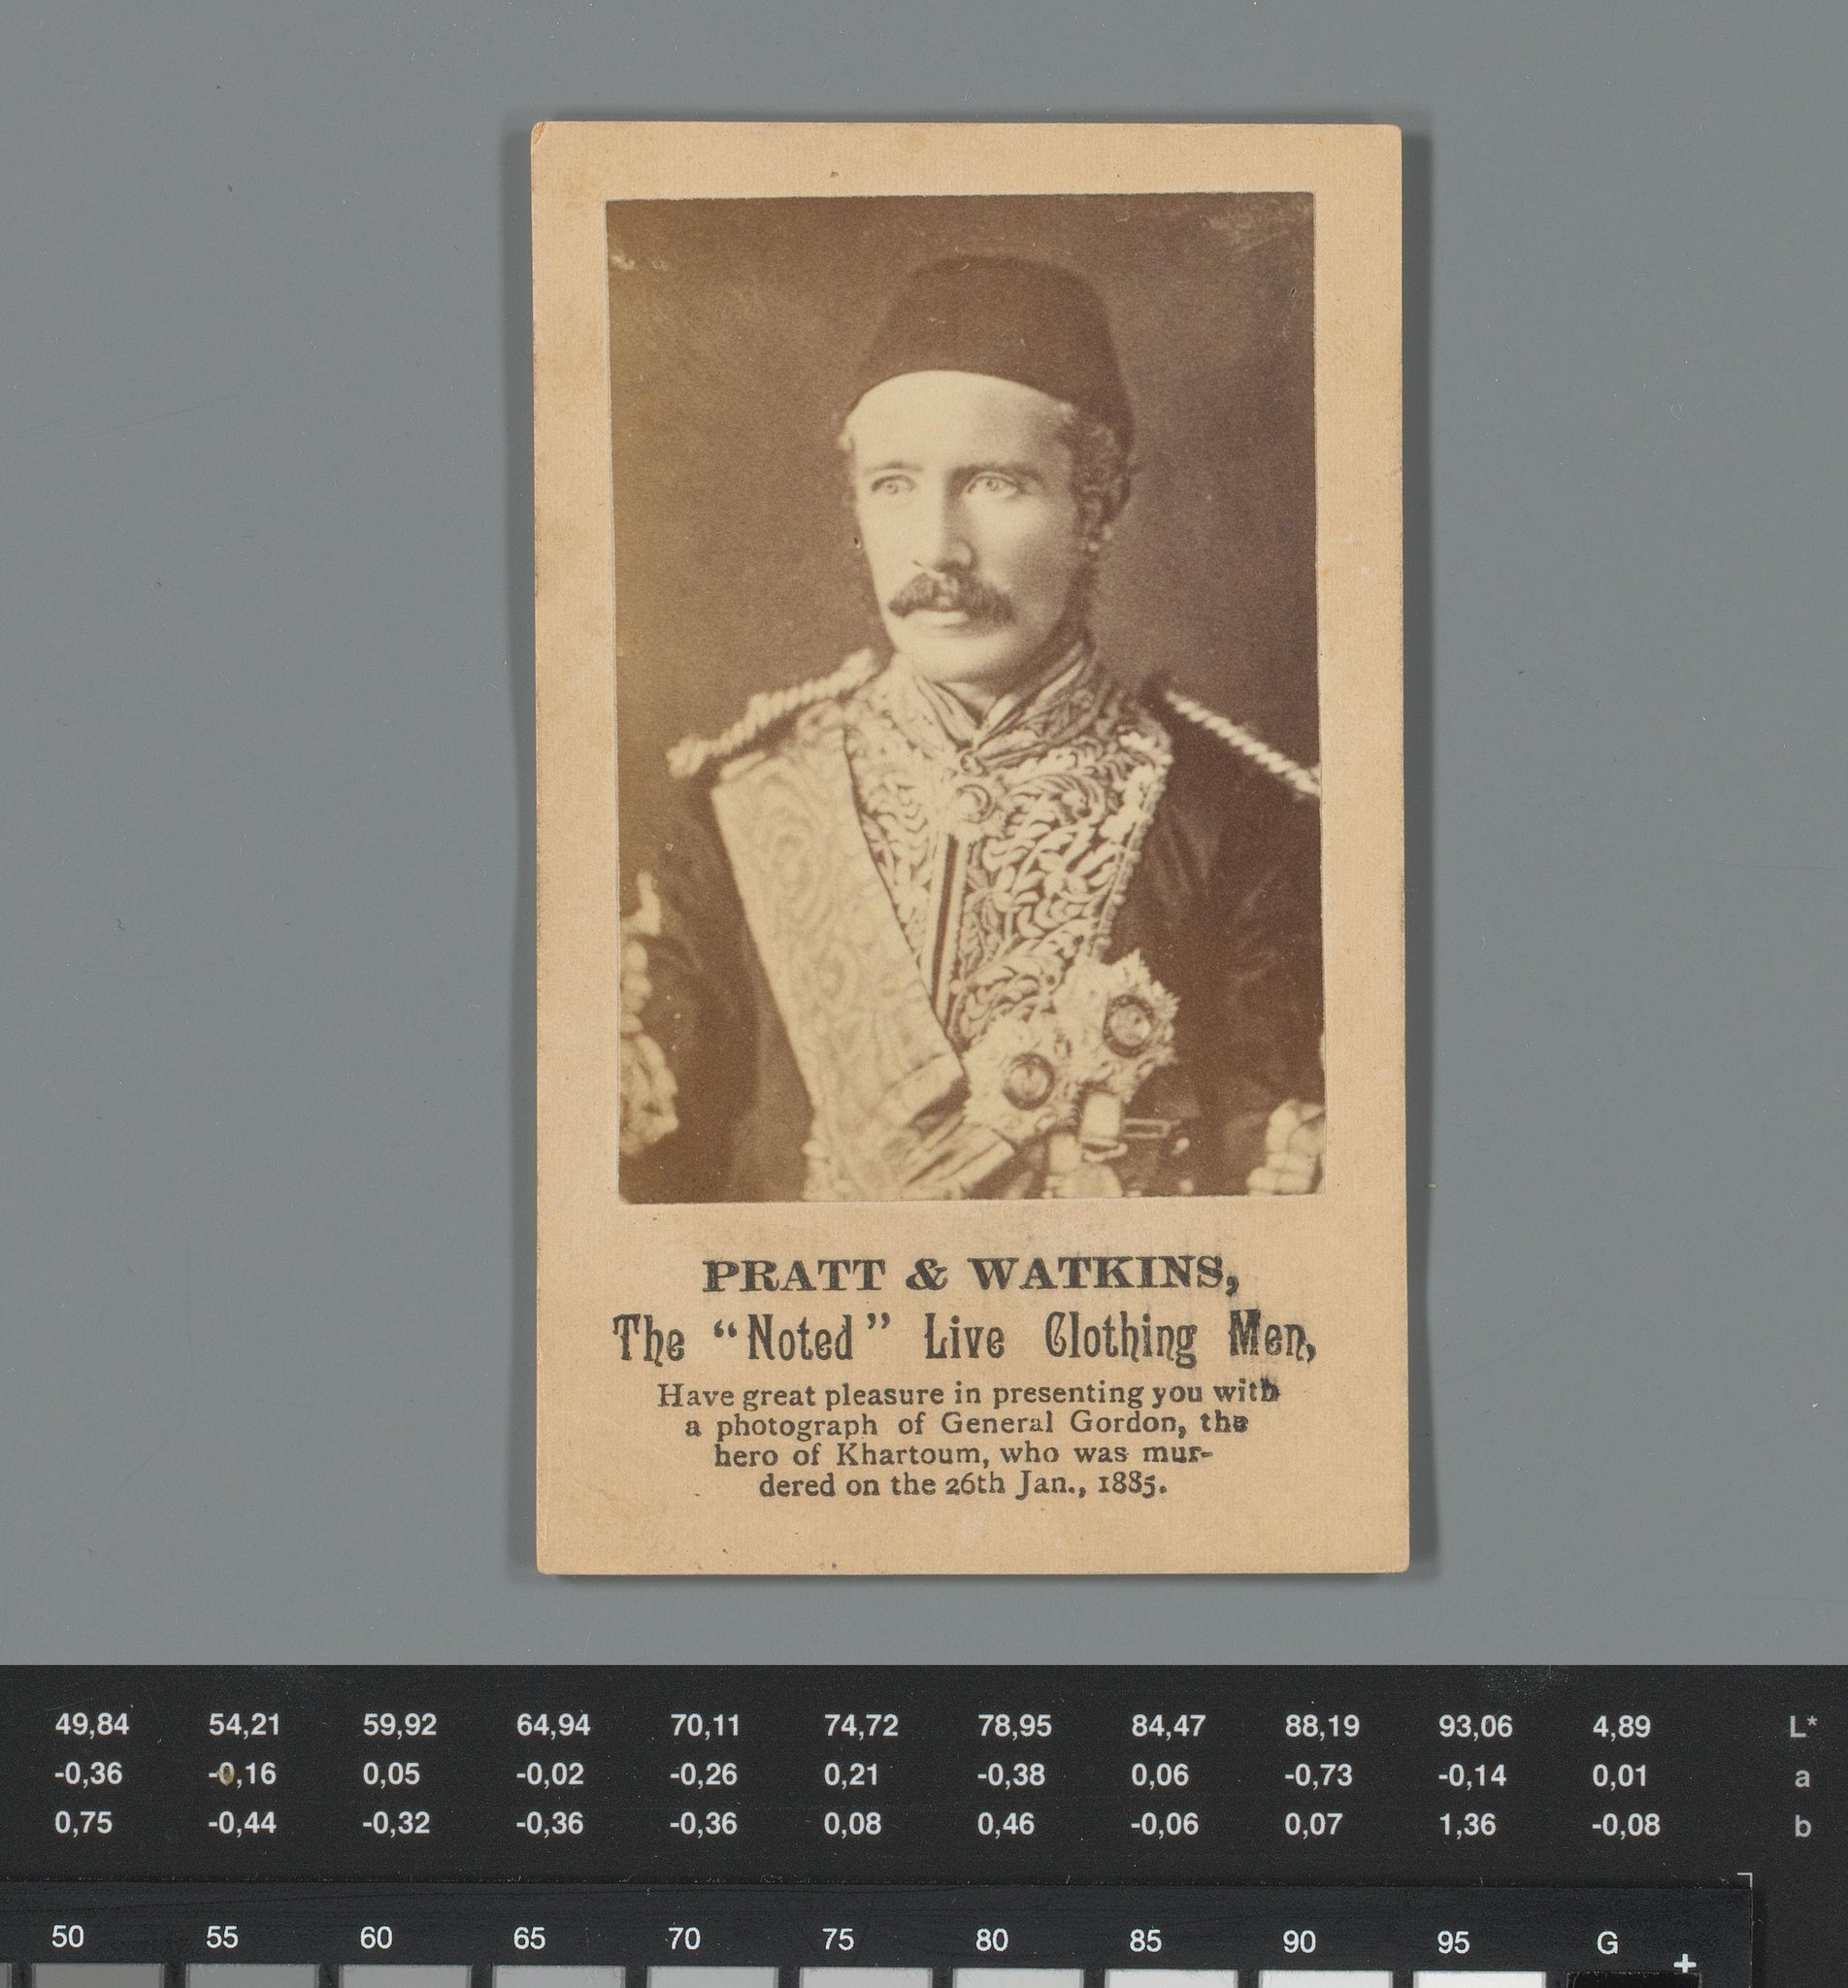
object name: photograph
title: Reclame voor kleding van Pratt & Watkins met portret van Charles George Gordon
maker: Anonymous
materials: cardboard, photographic support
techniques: albumen print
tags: engineer, charles george gordon, advertising, historical persons